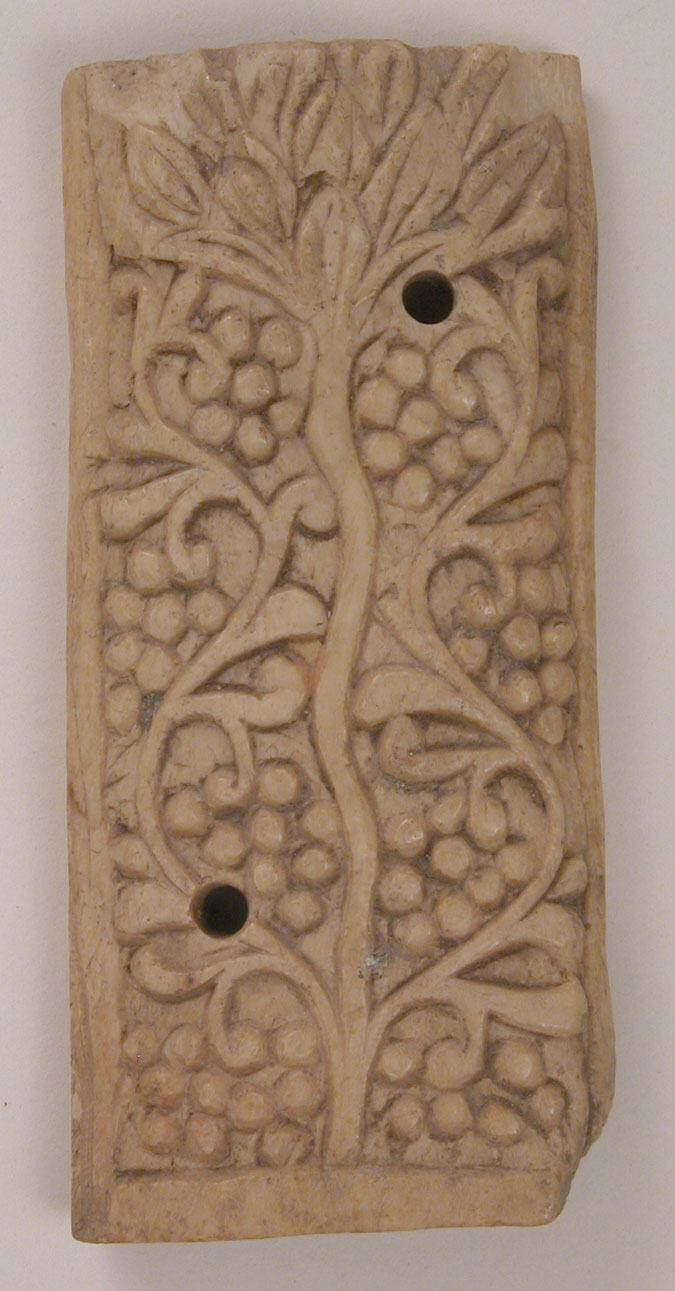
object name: plaque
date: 601-800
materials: bone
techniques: carving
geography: egypt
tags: plants